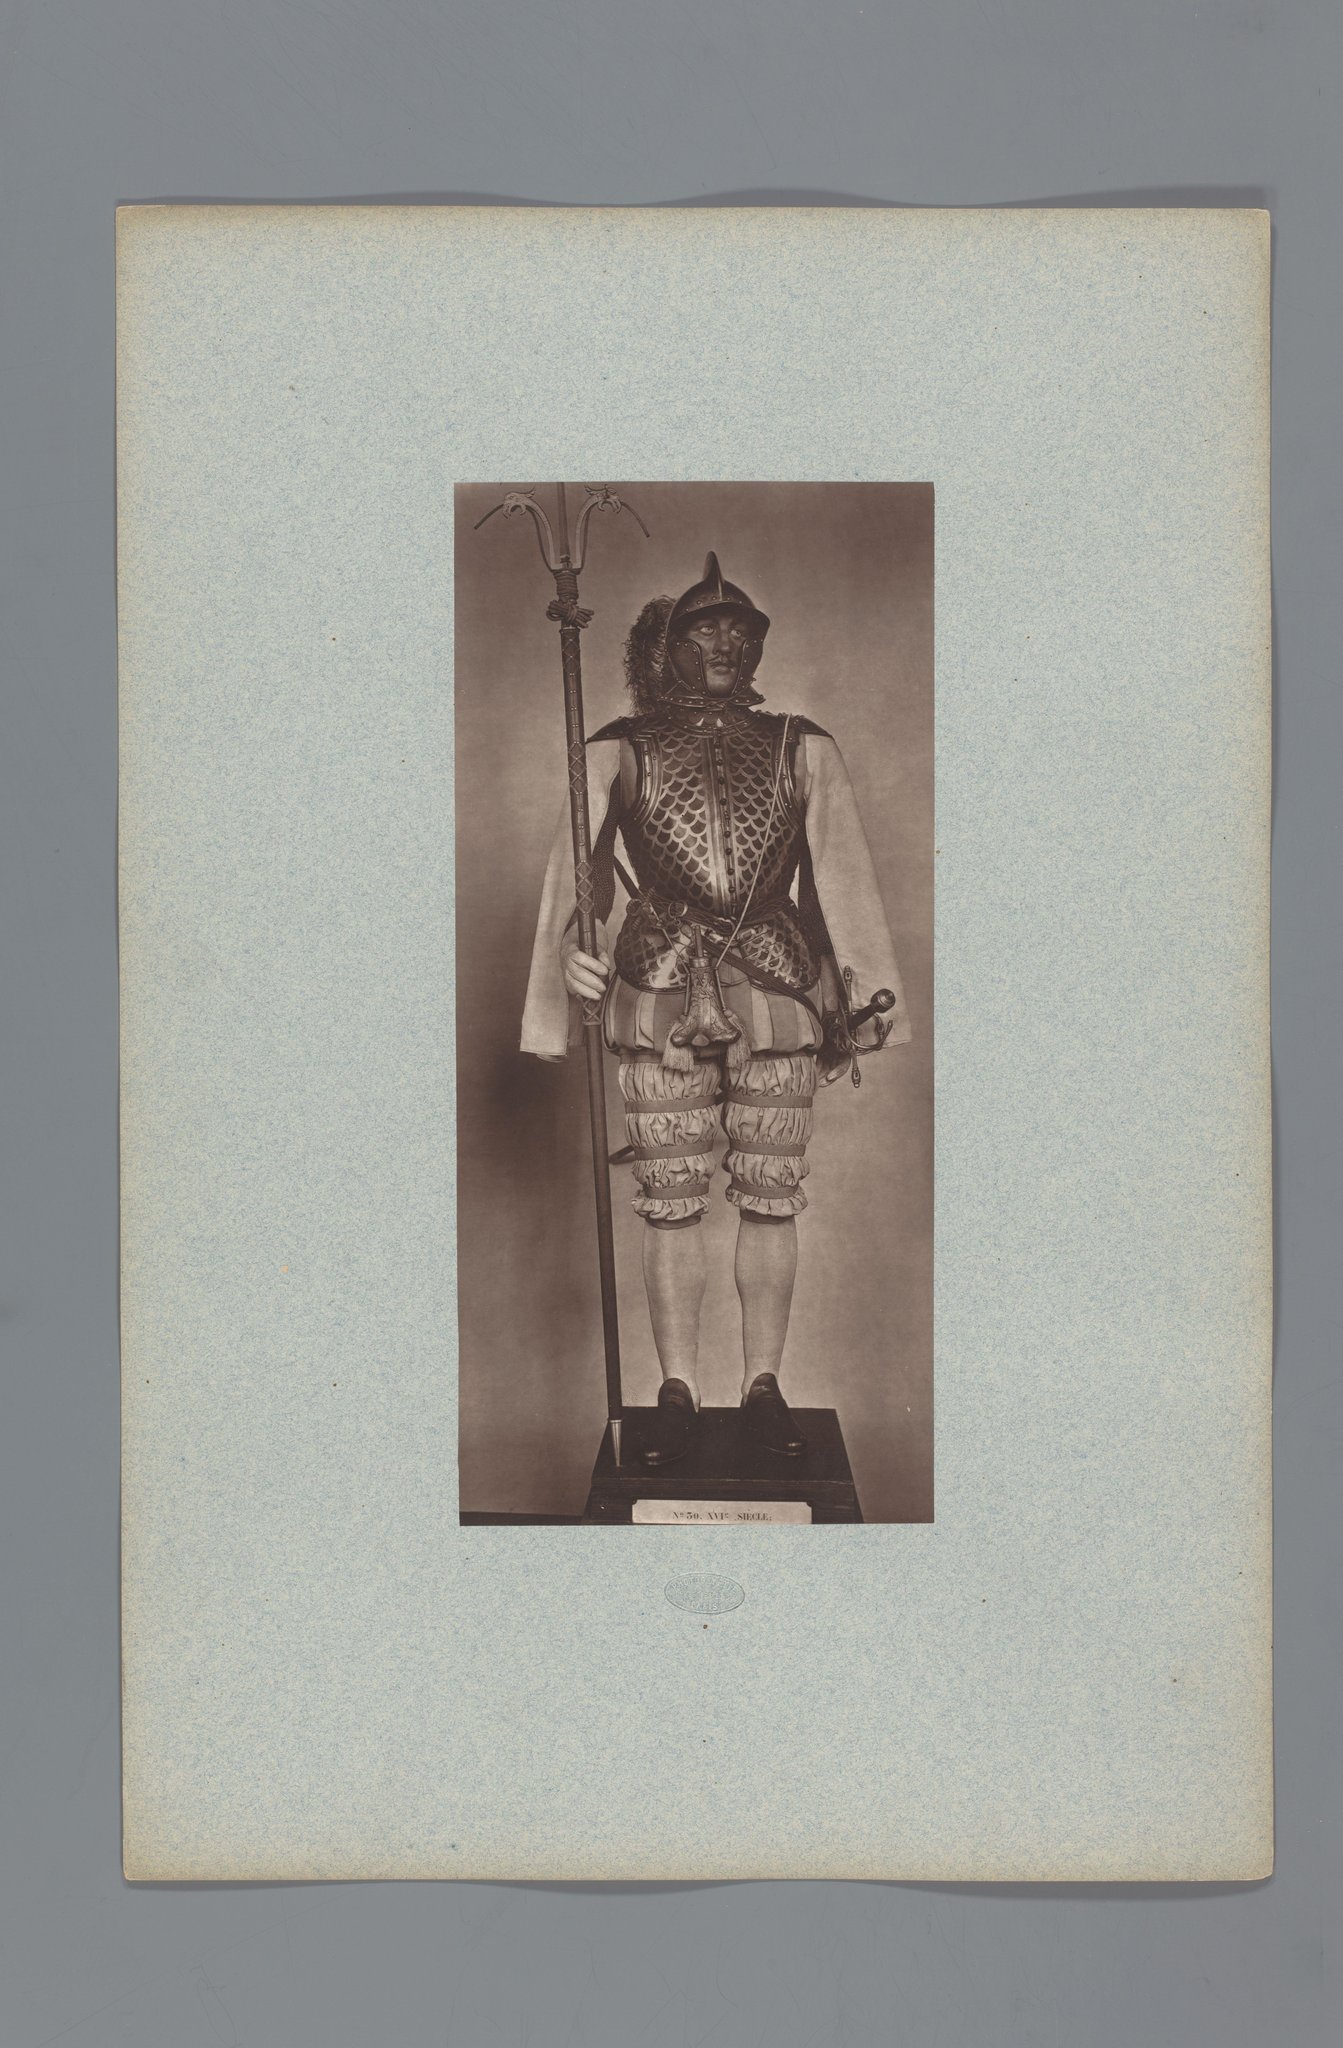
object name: photomechanical print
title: 16de-eeuws harnas met lans uit het leger van Hendrik III van Frankrijk, uit de collectie van het Musée d'Artillerie in Parijs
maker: Anonymous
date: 1877-1882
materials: paper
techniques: woodburytype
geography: paris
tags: armour, helved weapons, polearms (for striking, hacking, thrusting): lance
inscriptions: check stamp: ‘PHOTOGLYPTIE/ LEMERCIER ET Cie/ PARIS’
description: Deze prent maakt deel uit van een omslag met 36 prenten, een titelblad en een lijst van afbeeldingen.